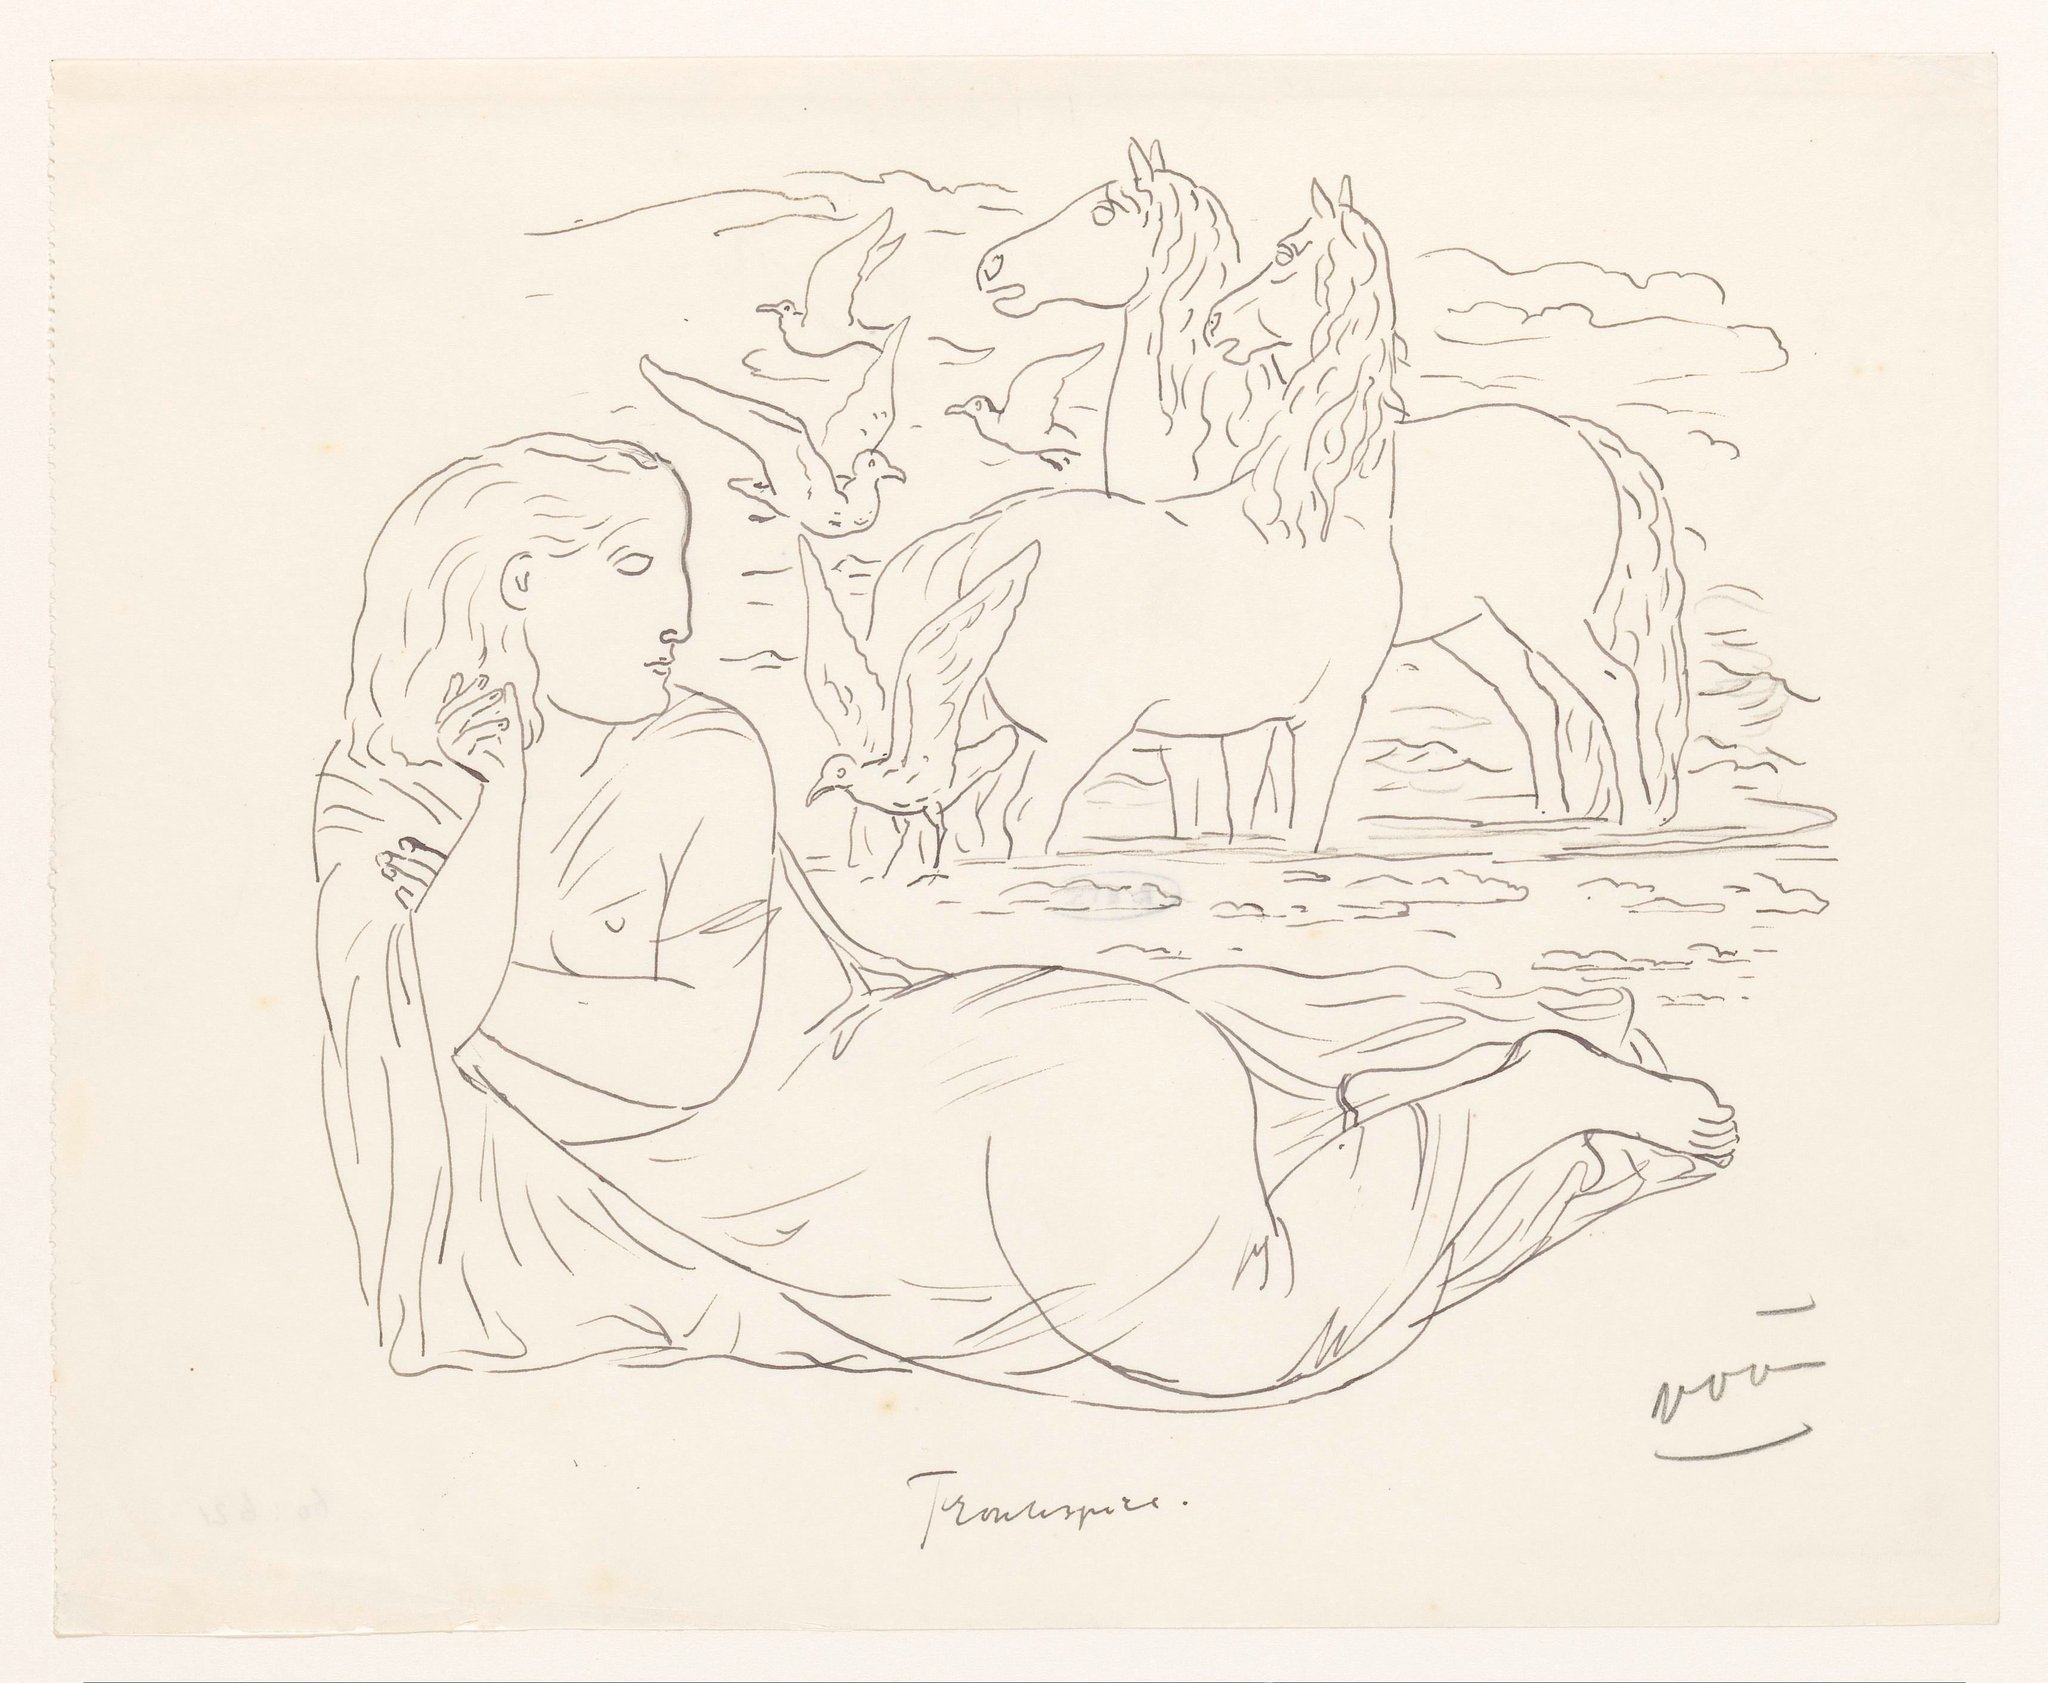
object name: drawing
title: Vrouw liggend aan het strand met twee paarden en enkele zeemeeuwen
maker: leo gestel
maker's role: draughtsman, print maker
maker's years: 1881-1941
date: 1891-1941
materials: ink, paper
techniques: pen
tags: lying on one side, with uplifted upper part of the body and leaning on the arm - aa - female human figure, shore-birds and wading-birds: gull, horse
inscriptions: collector's mark: Lugt 2228, watermark: ‘GW/ PAPIER/ 1671’, :